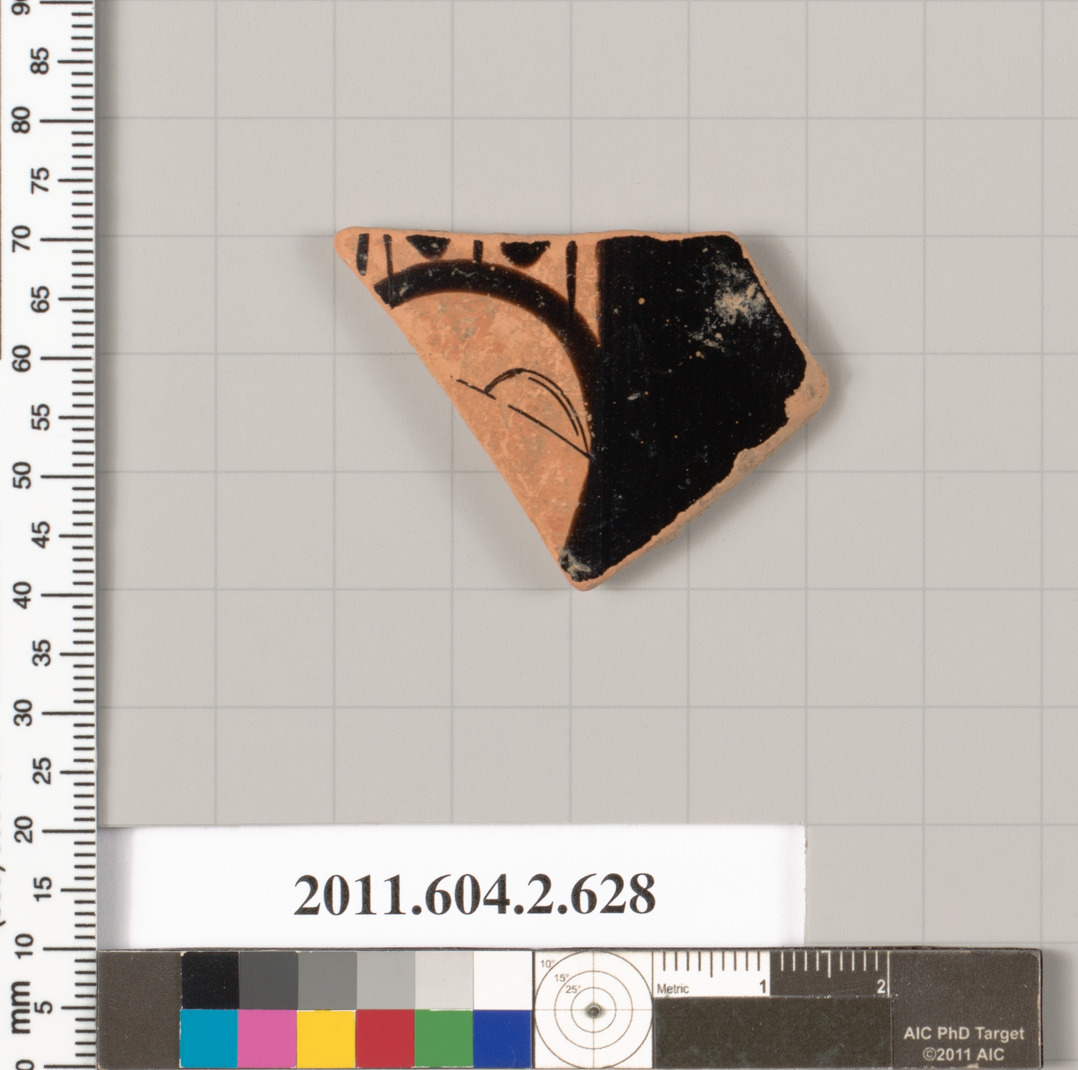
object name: column krater fragment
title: Terracotta fragment of a column-krater (bowl for mixing wine and water)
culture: greek, attic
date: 460-440 BCE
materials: terracotta